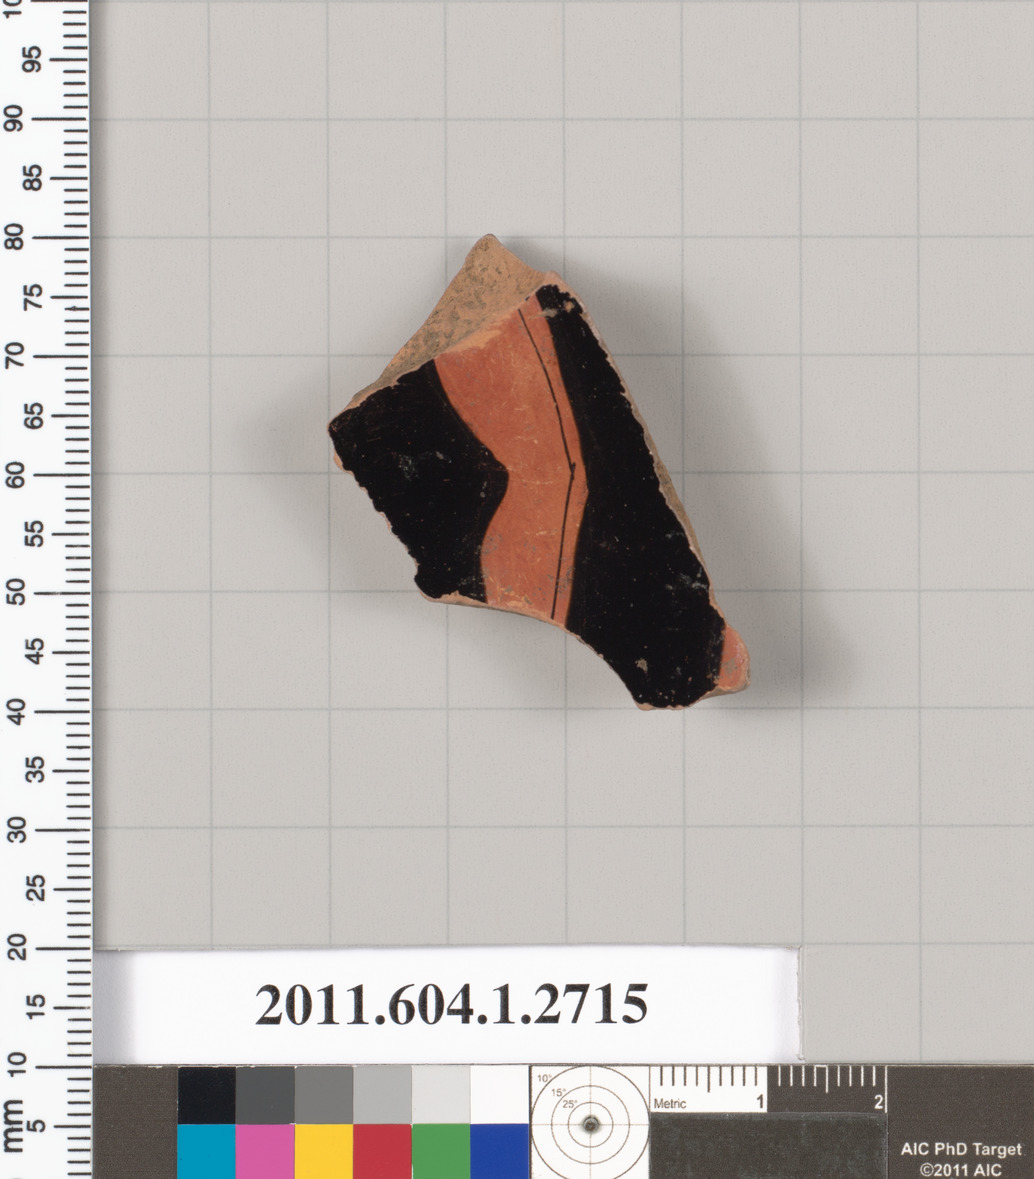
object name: kylix fragment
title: Terracotta fragment of a kylix (drinking cup)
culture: greek, attic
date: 490-480 BCE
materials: terracotta